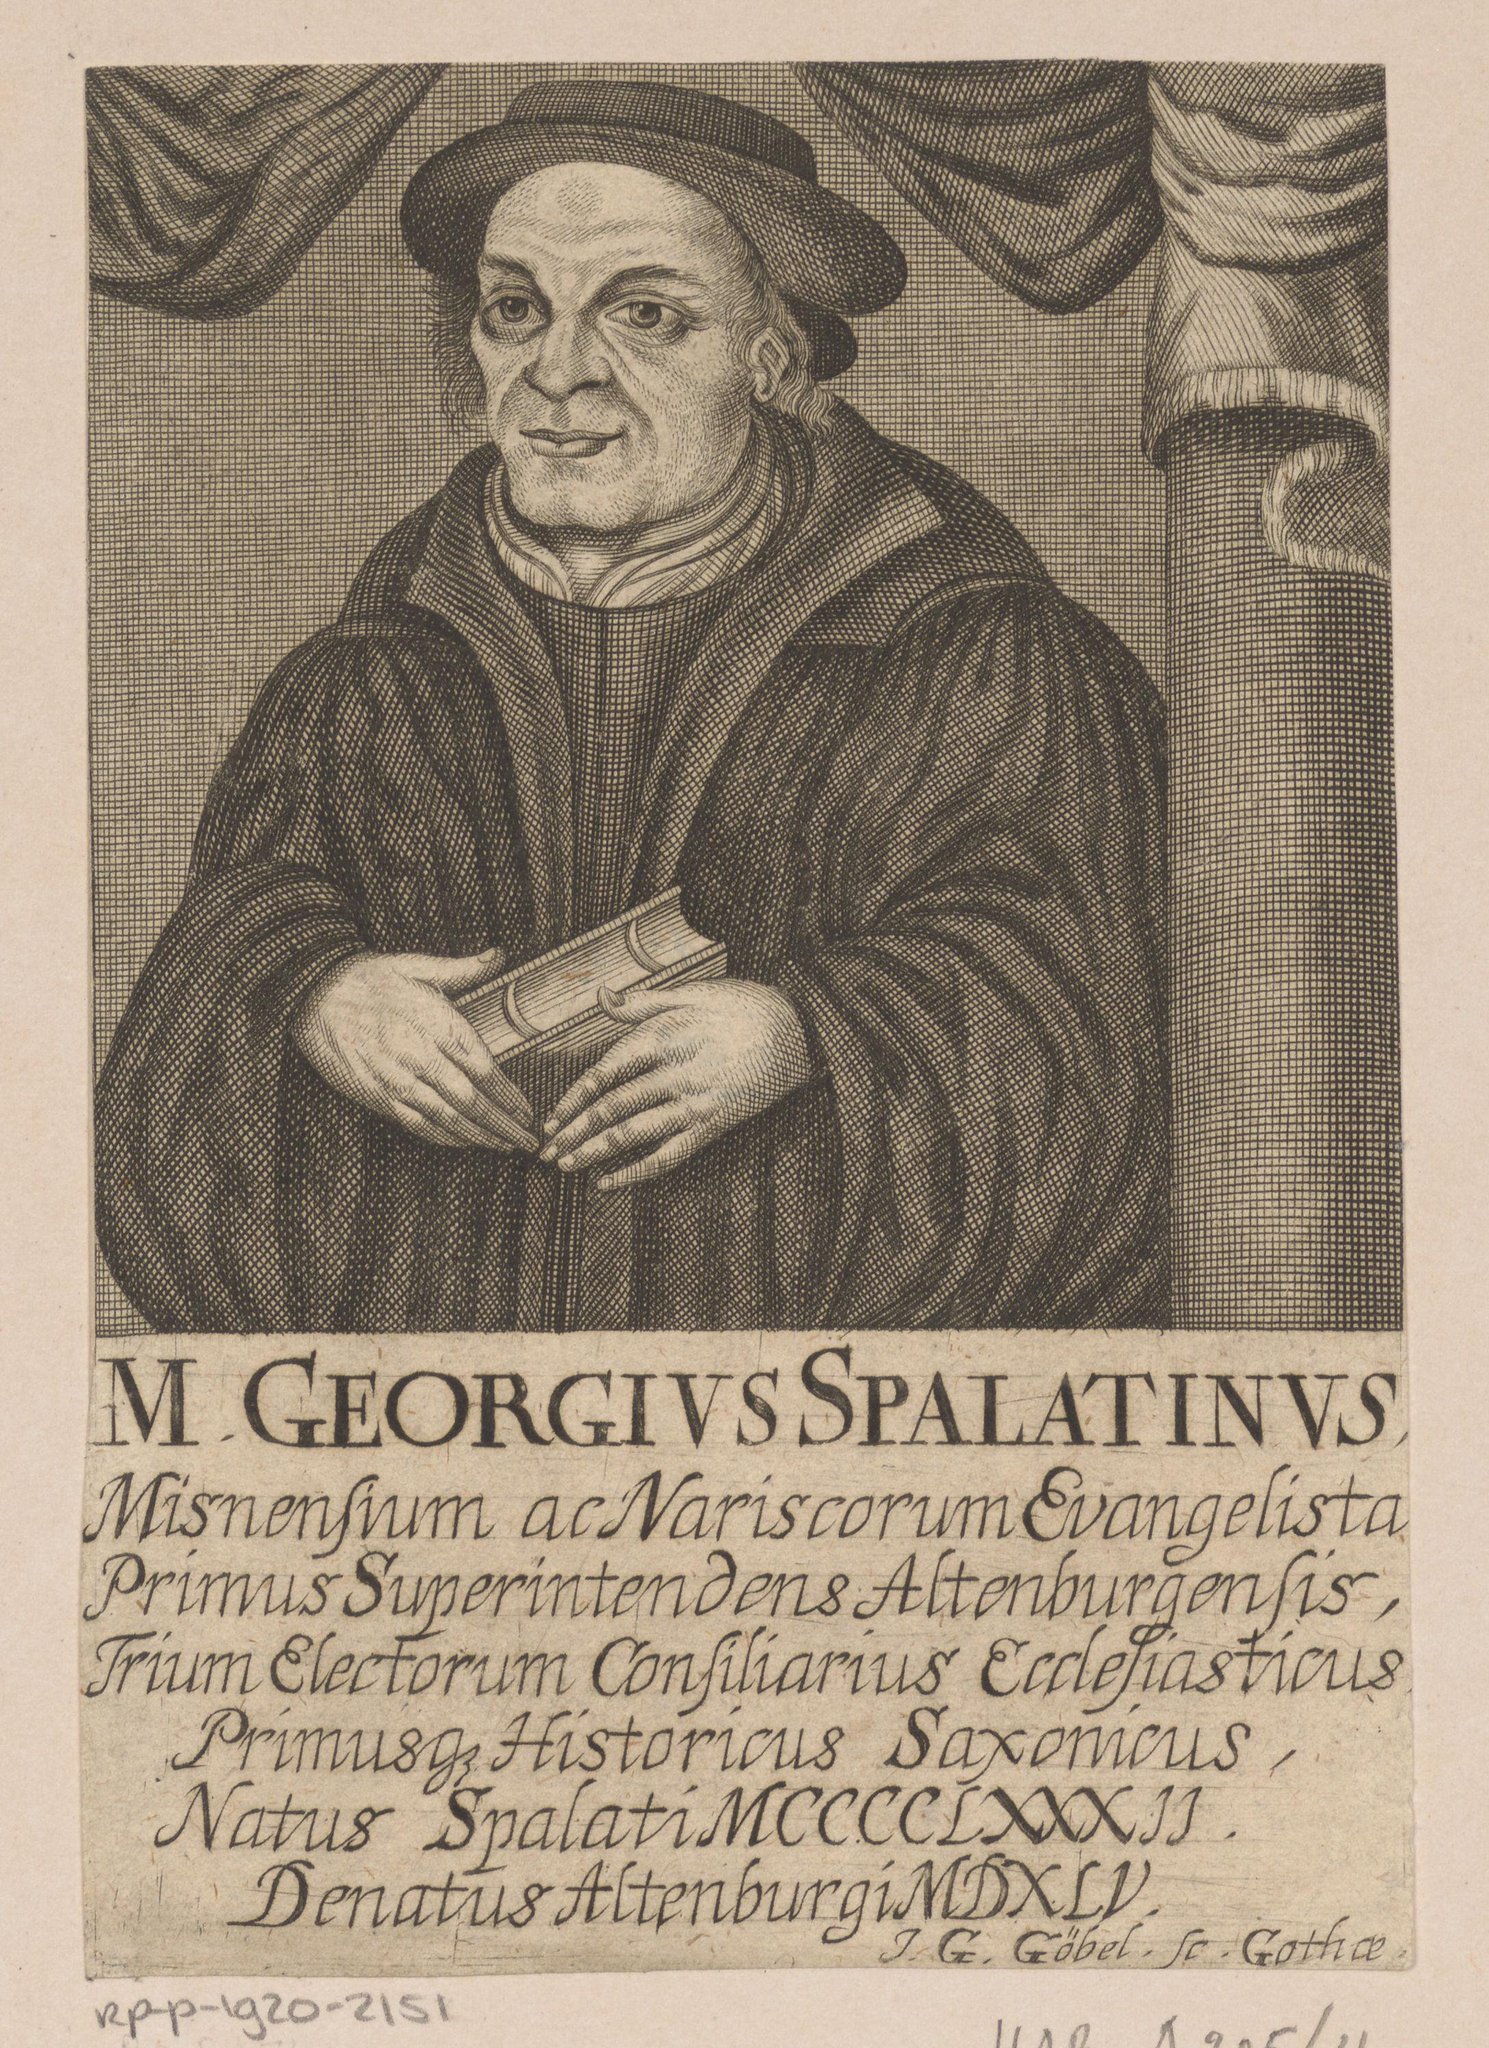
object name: print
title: Portret van Georg Spalatin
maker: johann georg göbel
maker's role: print maker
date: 1662-1719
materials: paper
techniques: engraving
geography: gotha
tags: priest, theologian, historical persons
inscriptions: collector's mark: Lugt 2228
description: Met zesregelig onderschrift in het Latijn.